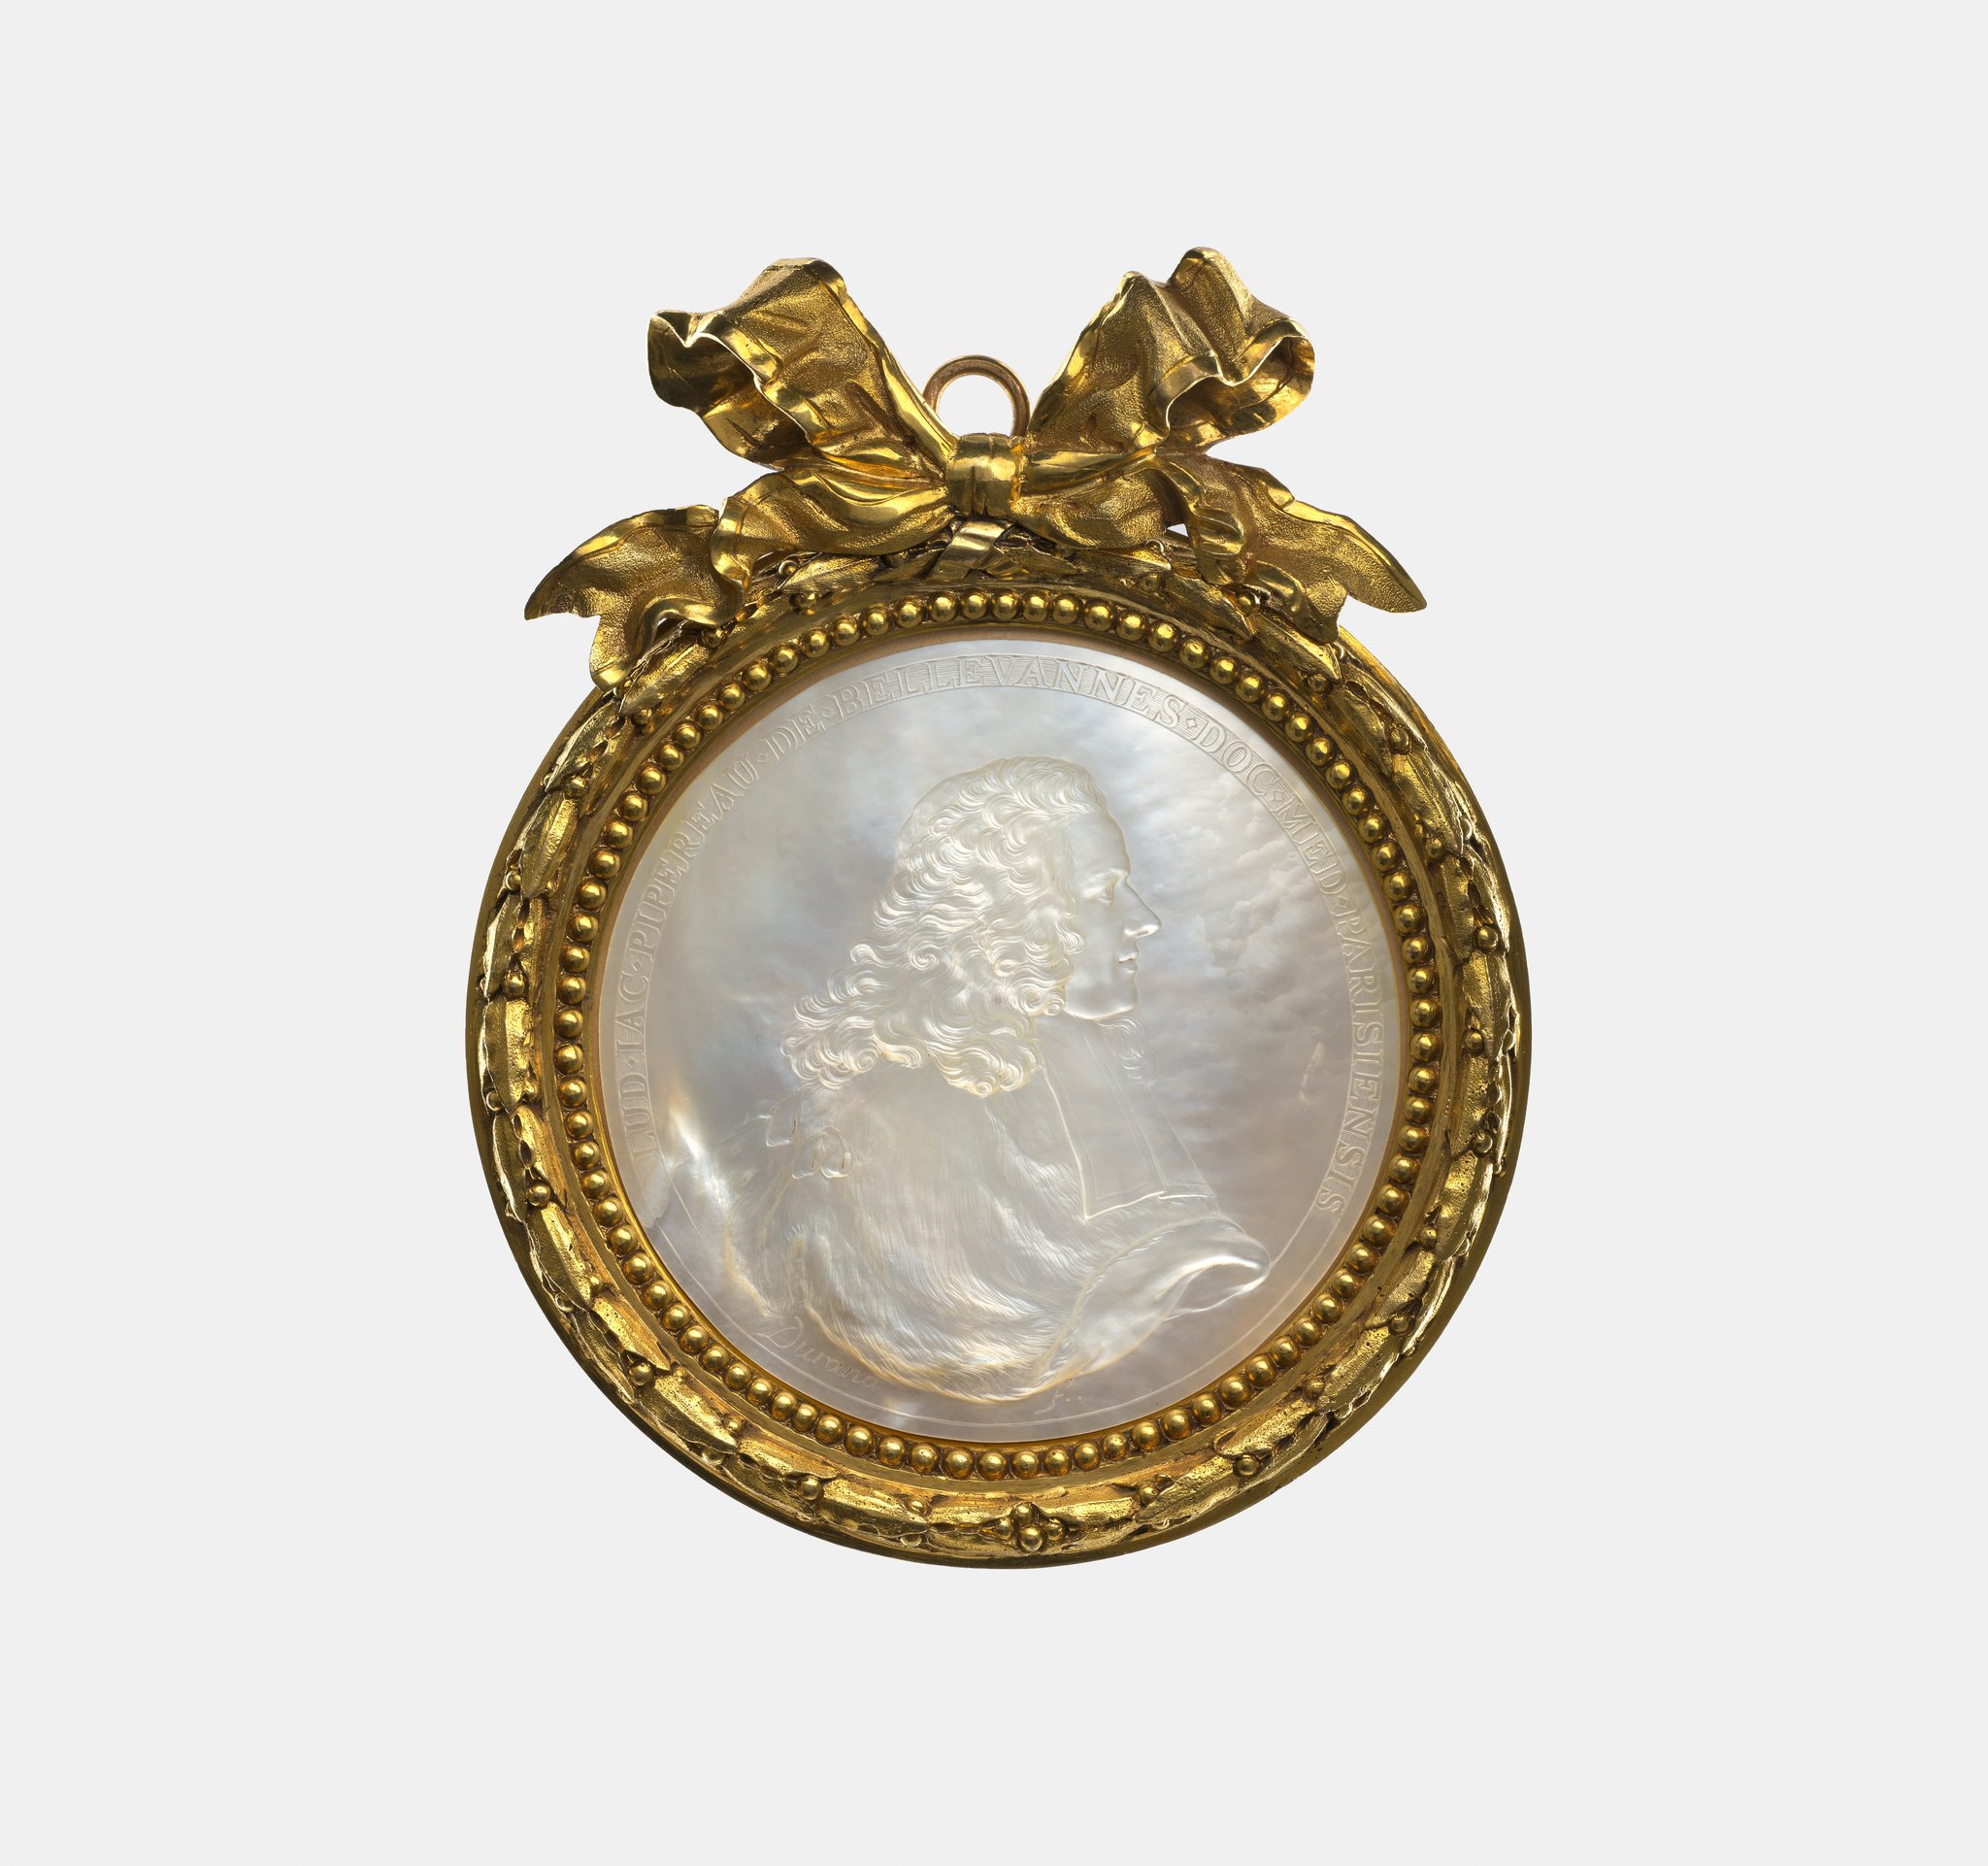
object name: relief portrait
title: Louis-Jacques Pipereau de Bellevannes (d. 1787)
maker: pierre-louis durand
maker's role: maker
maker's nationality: french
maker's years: 1710-1797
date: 1740-1749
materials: gilt bronze, mother of pearl